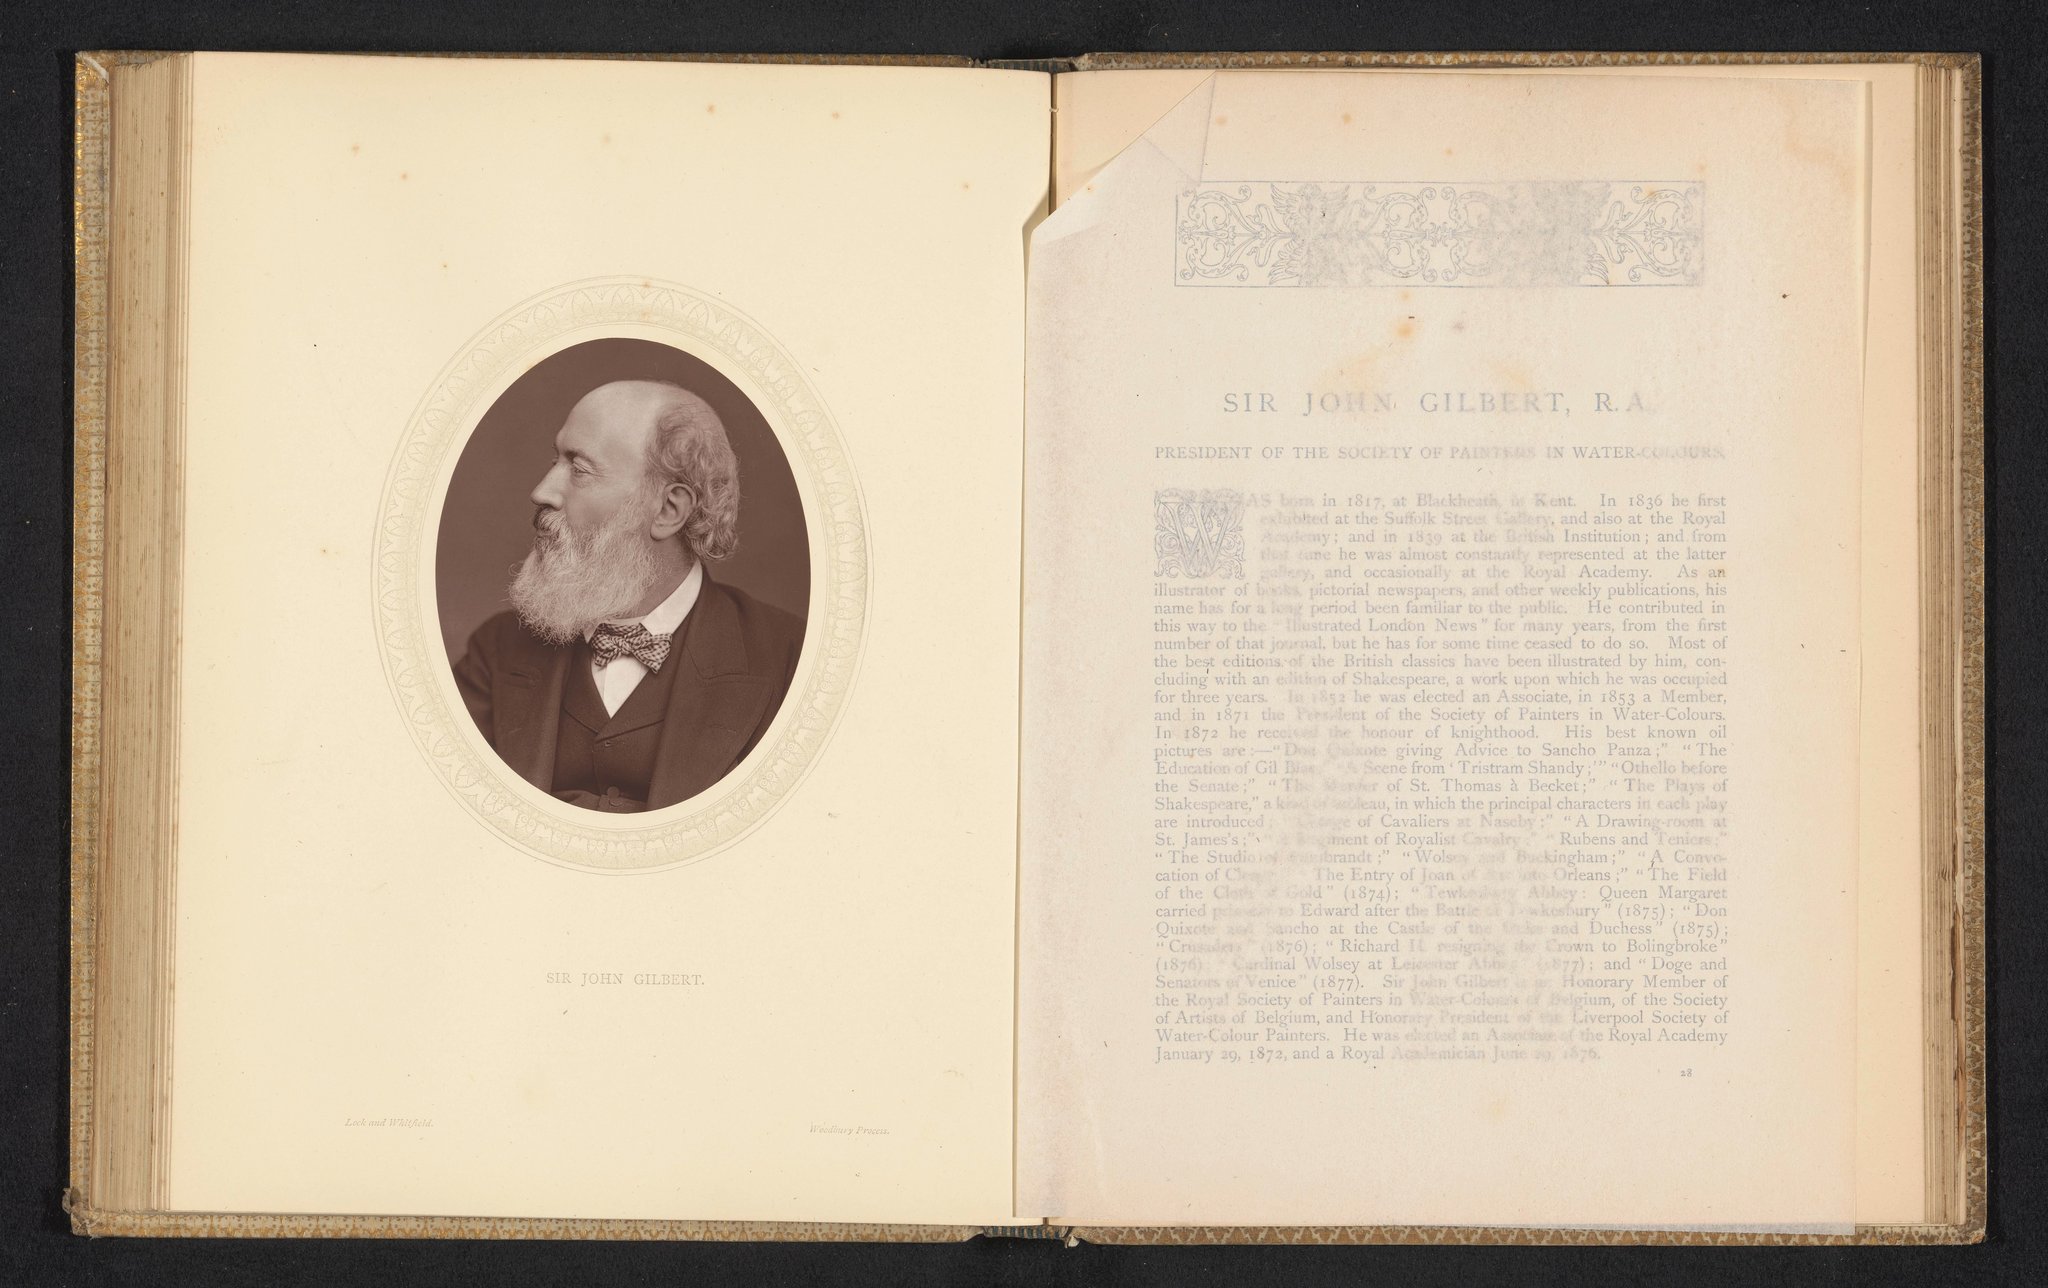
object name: page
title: Sir John Gilbert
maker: Anonymous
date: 1871-1876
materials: paper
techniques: woodburytype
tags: painter, john gilbert, portrait, self-portrait of painter, historical persons (portraits and scenes from the life) (+ (full) bust portrait)